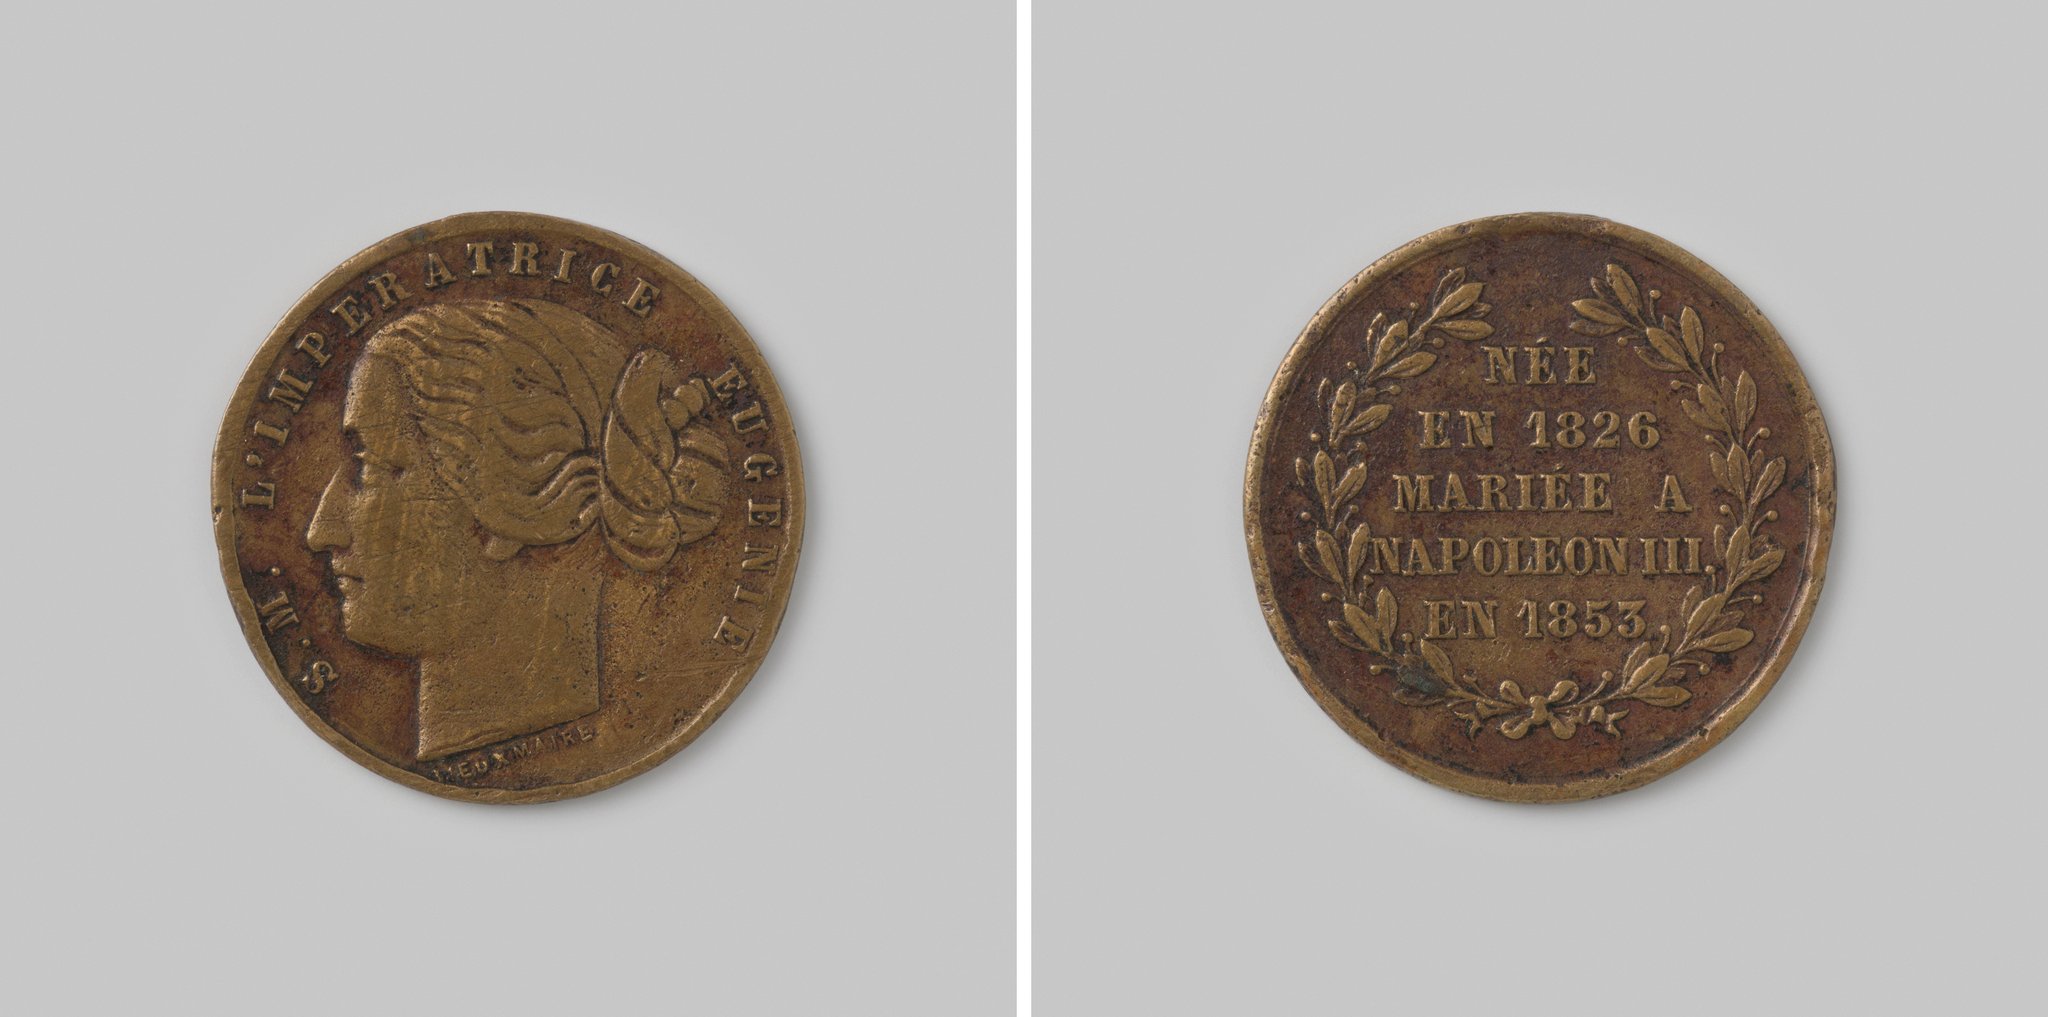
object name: history medal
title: Huwelijk van Napoleon III met Eugenia Maria de Guzman 1853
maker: vieuxmaire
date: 1853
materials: brass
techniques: striking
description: Messing penning, op de voorzijde het portret van Keizerin Eugenie naar links met omschrift, op de keerzijde vijf regels tekst tussen samengestrikte lauwertakken.